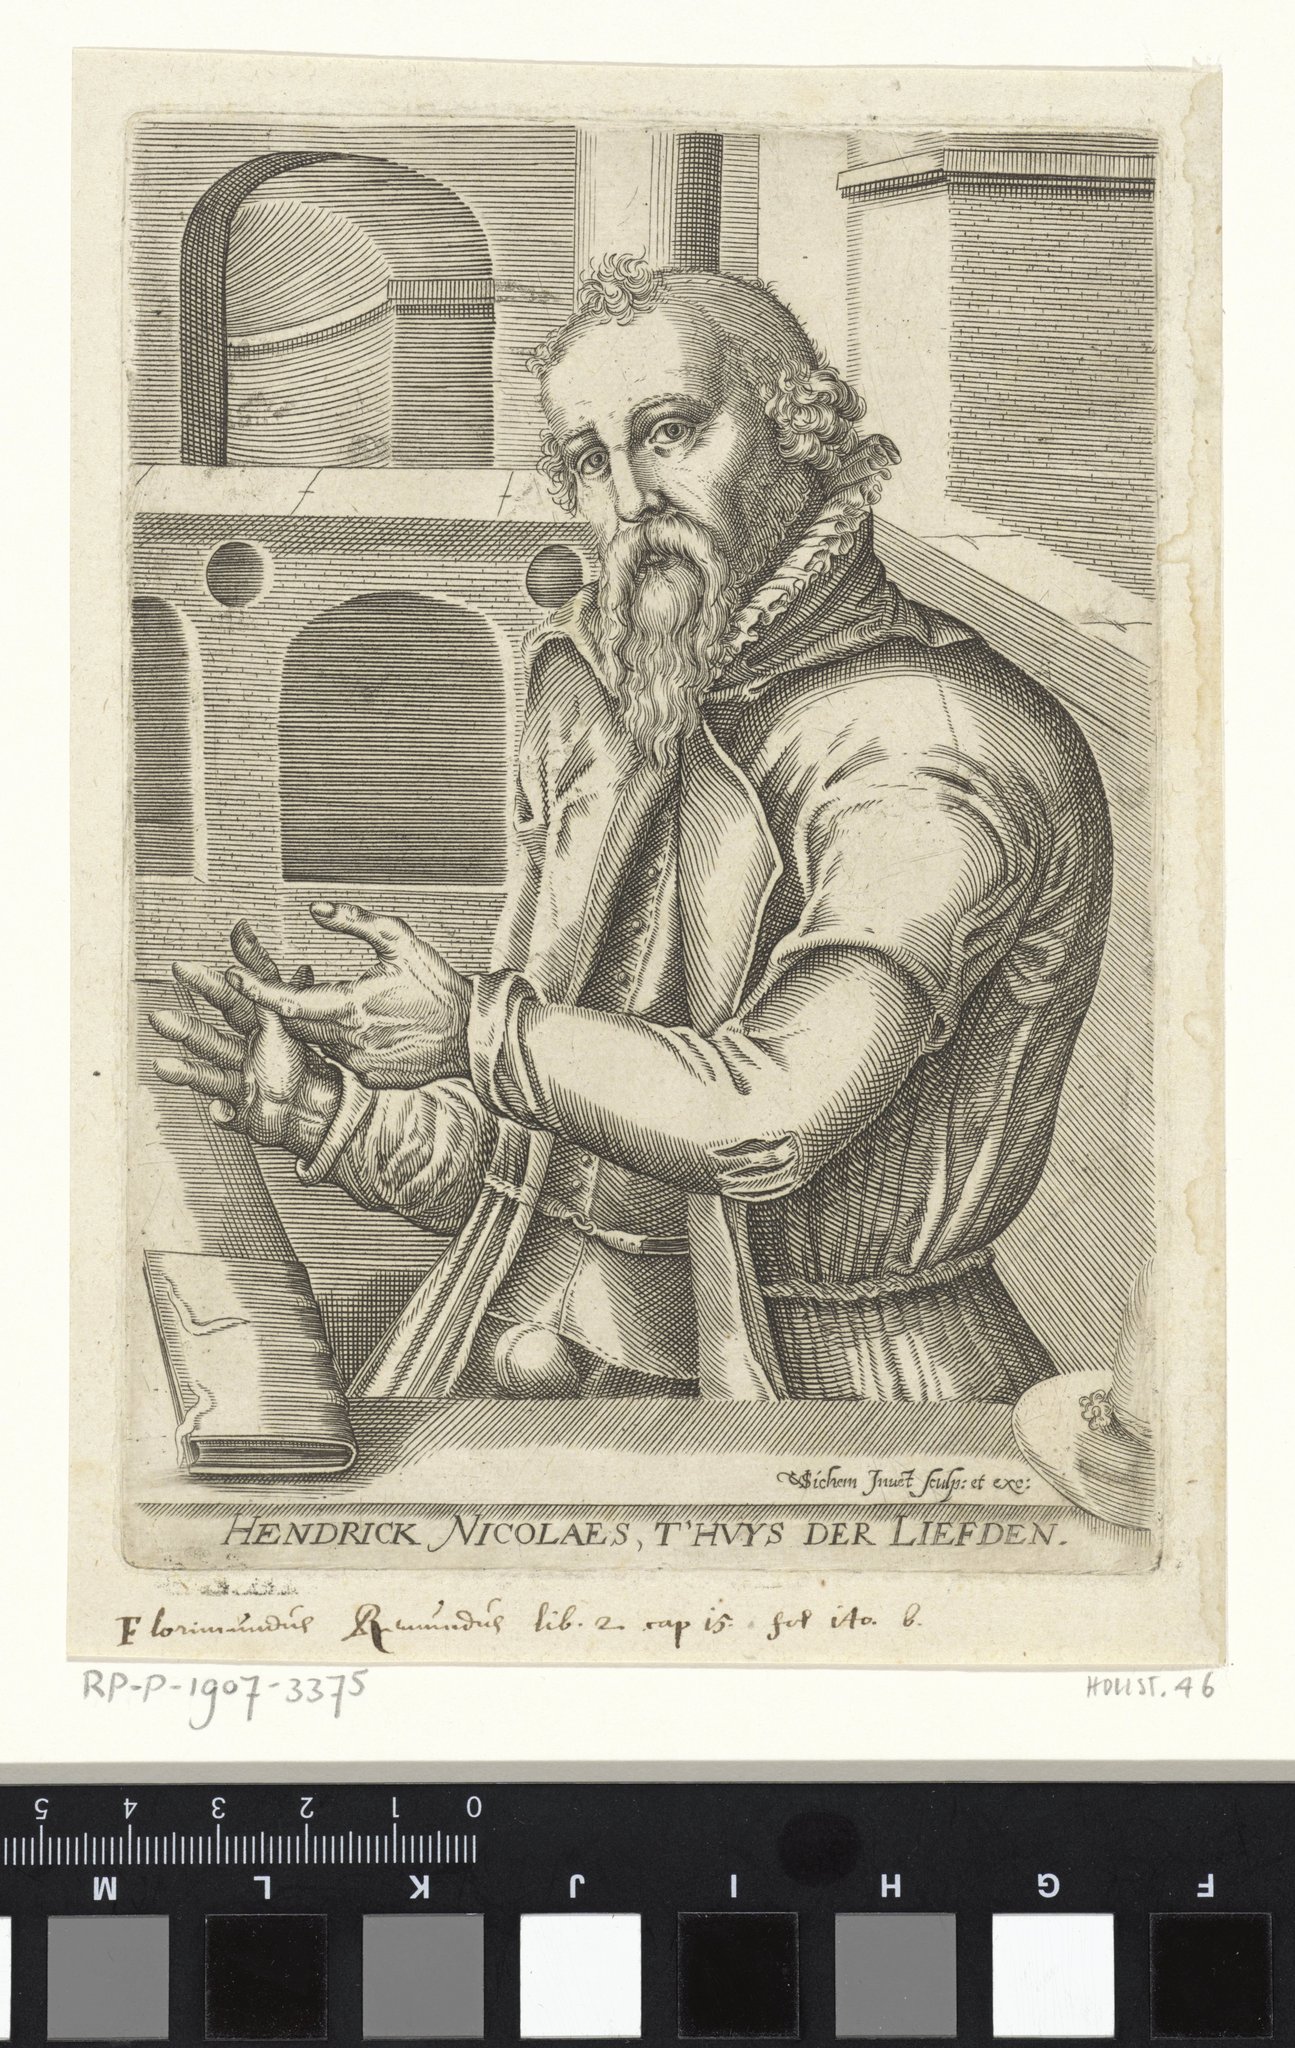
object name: print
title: Portret van Hendrik Niclaes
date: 1677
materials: paper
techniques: engraving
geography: middelburg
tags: hendrik niclaes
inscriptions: collector's mark: Lugt 2228, inscription: ‘Florimundus Remundus lib. 3, cap. 15 fol. ito v’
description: Oorspronkelijk gemaakt voor: 'Historische beschrijvinge ende affbeeldinge der voorneemste hooft ketteren', Amsterdam, C. van Sichem, 1608. Deze prent komt in deze staat voor in: C. van Sichem, 'Het tooneel der hooft-ketteren, bestaande in verscheyde afbeeltsels...', Middelburg, Wilhelmus Goeree, 1677.